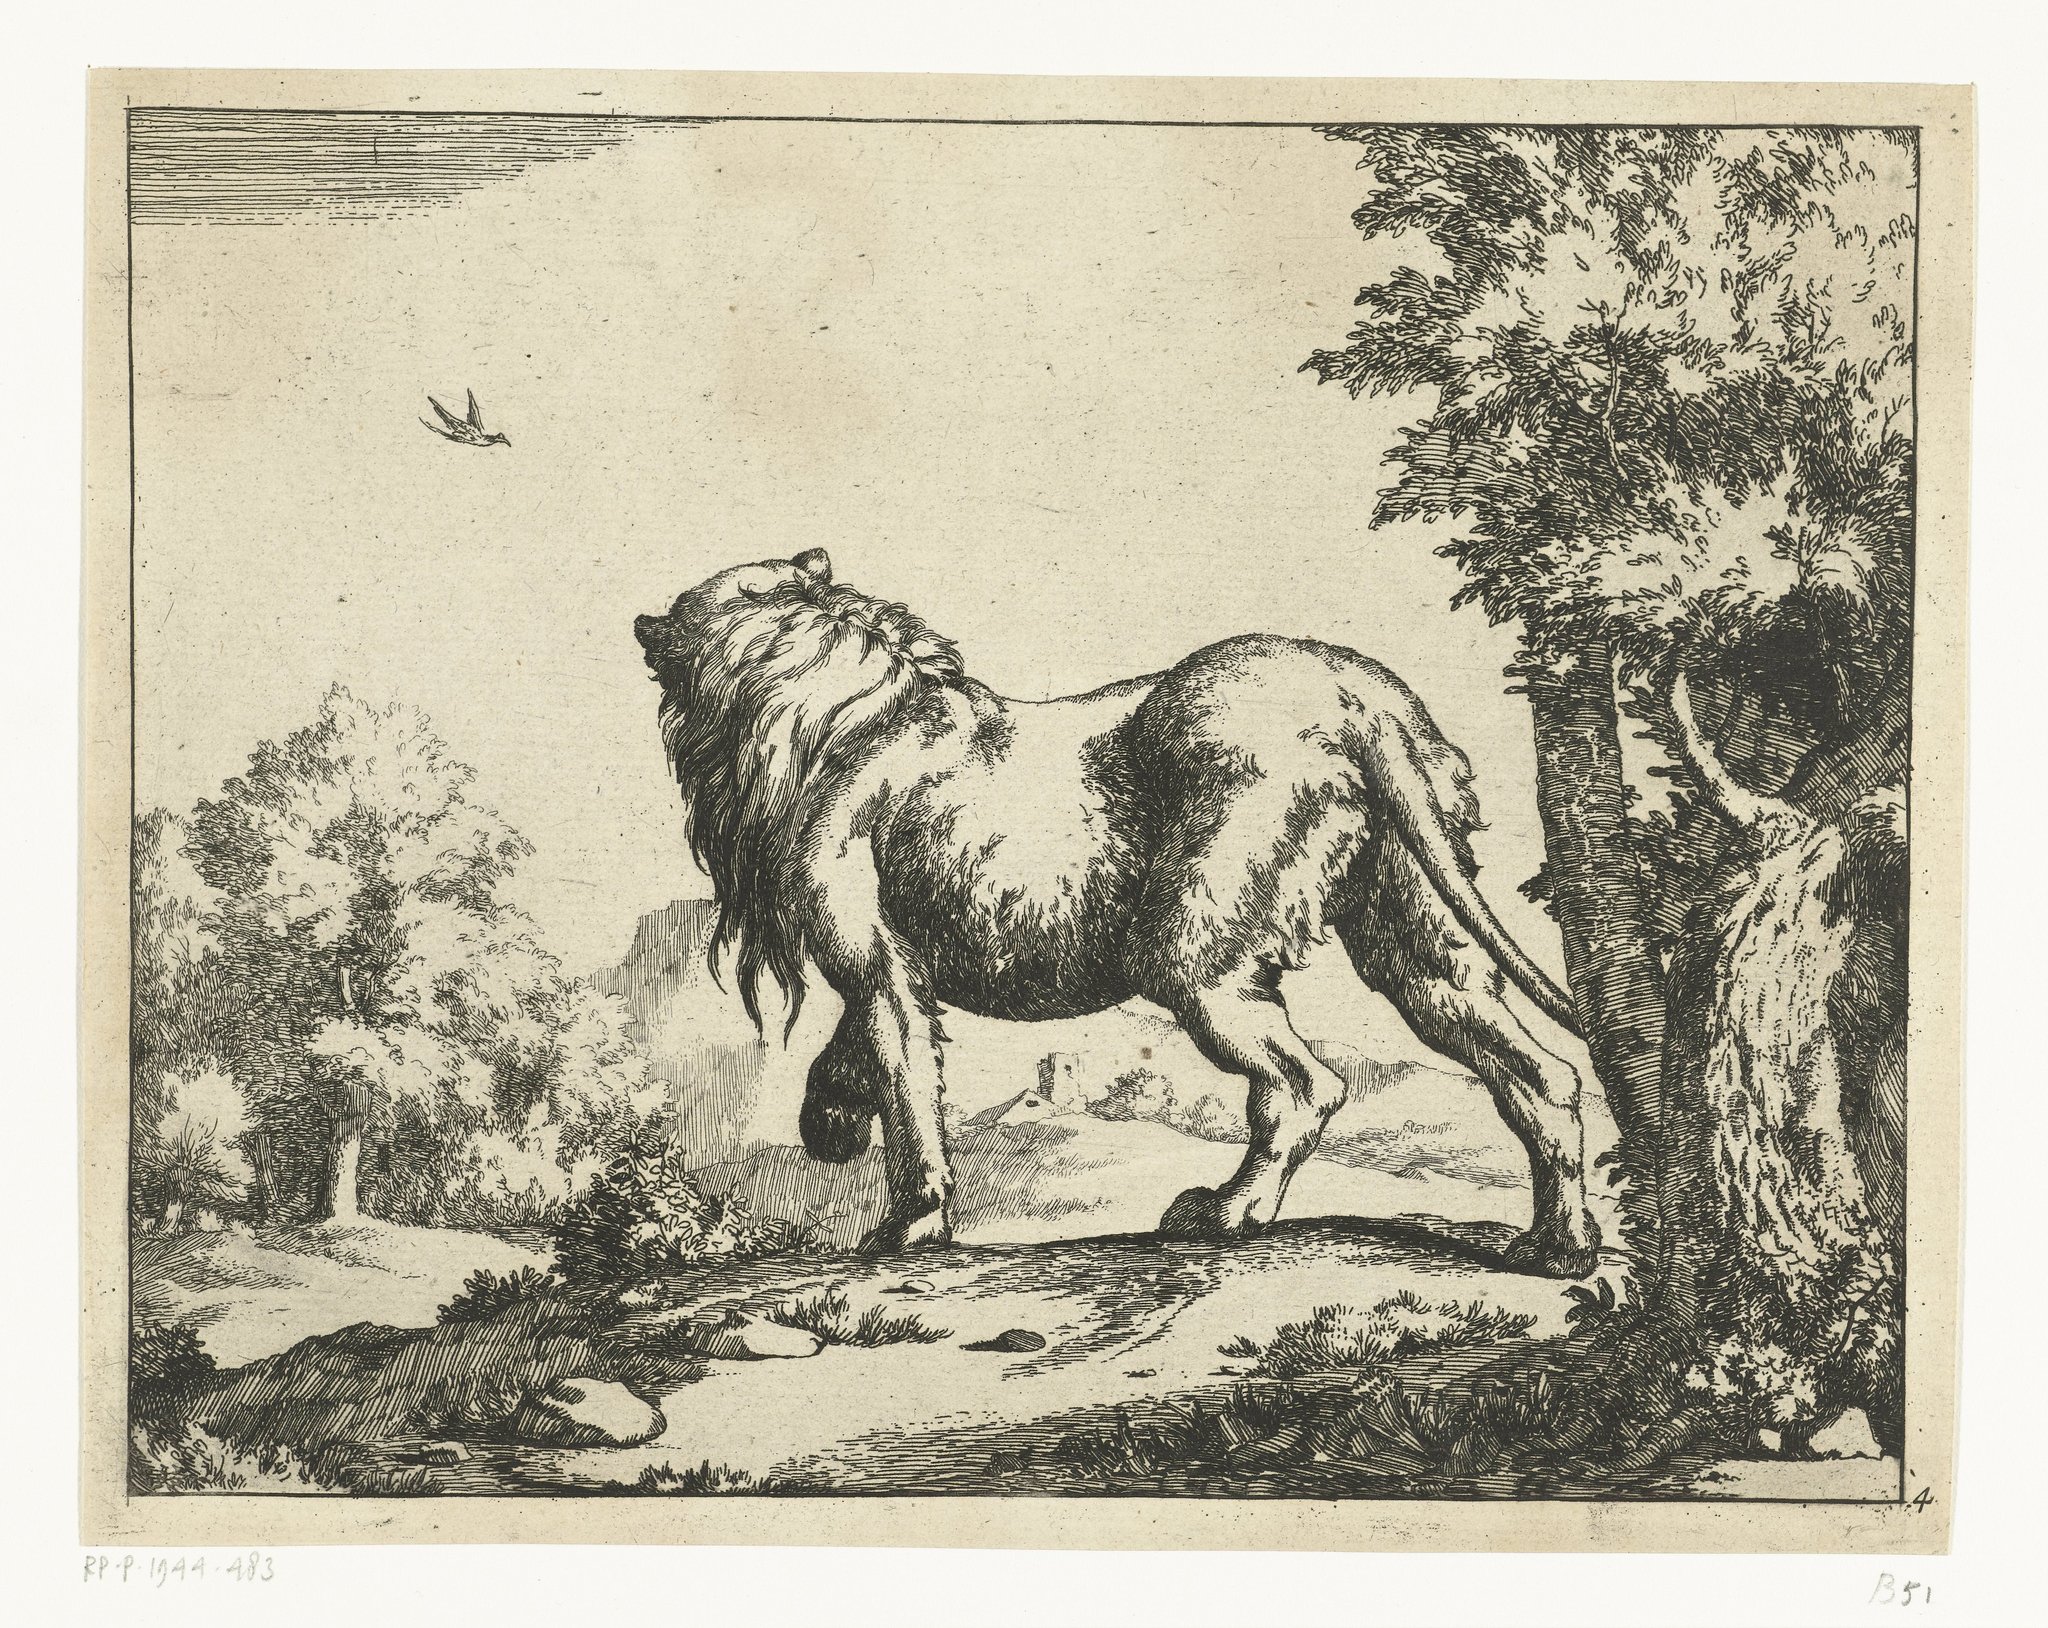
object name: print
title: Staande leeuw van achter gezien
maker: marcus de bye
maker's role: print maker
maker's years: 1639-1688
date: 1664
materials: paper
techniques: etching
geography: the hague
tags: beasts of prey, predatory animals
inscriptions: collector's mark: Lugt 2228